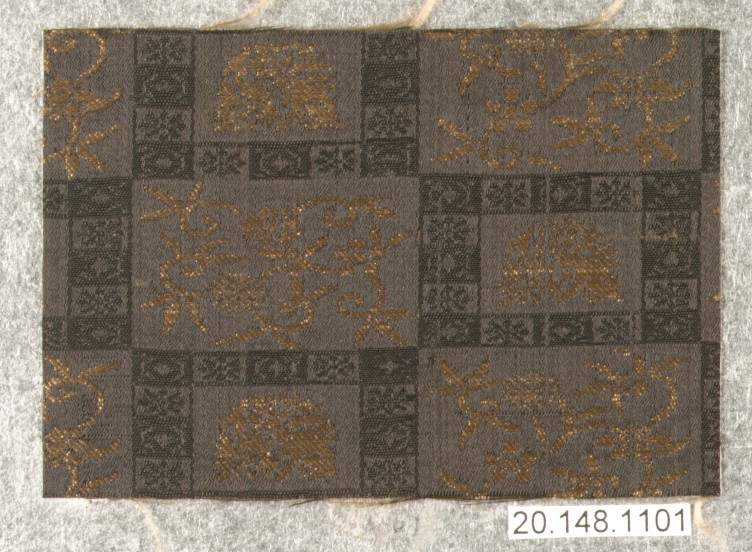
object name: piece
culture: japanese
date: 1701-1800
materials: silk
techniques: compound weave